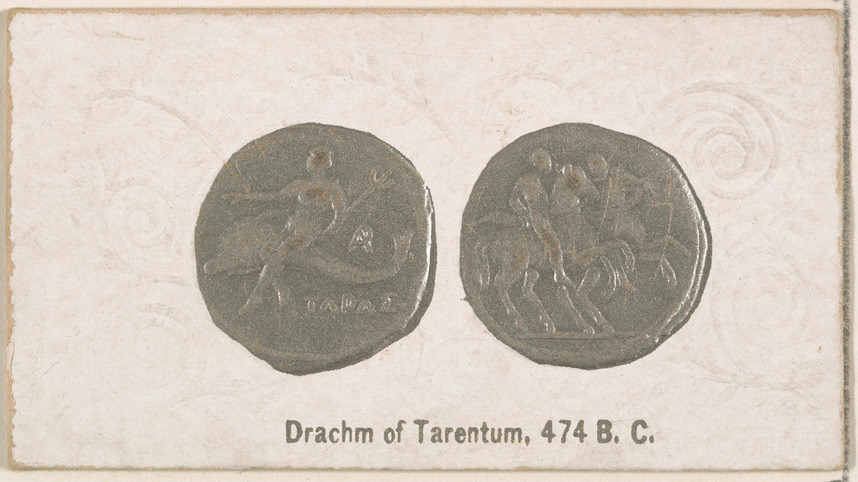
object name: print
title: Drachm of Tarentum, 474 B.C., from the Ancient Coins series (N180) issued by Wm. S. Kimball & Co.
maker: william s. kimball & company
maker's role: publisher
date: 1888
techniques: color lithograph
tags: coins